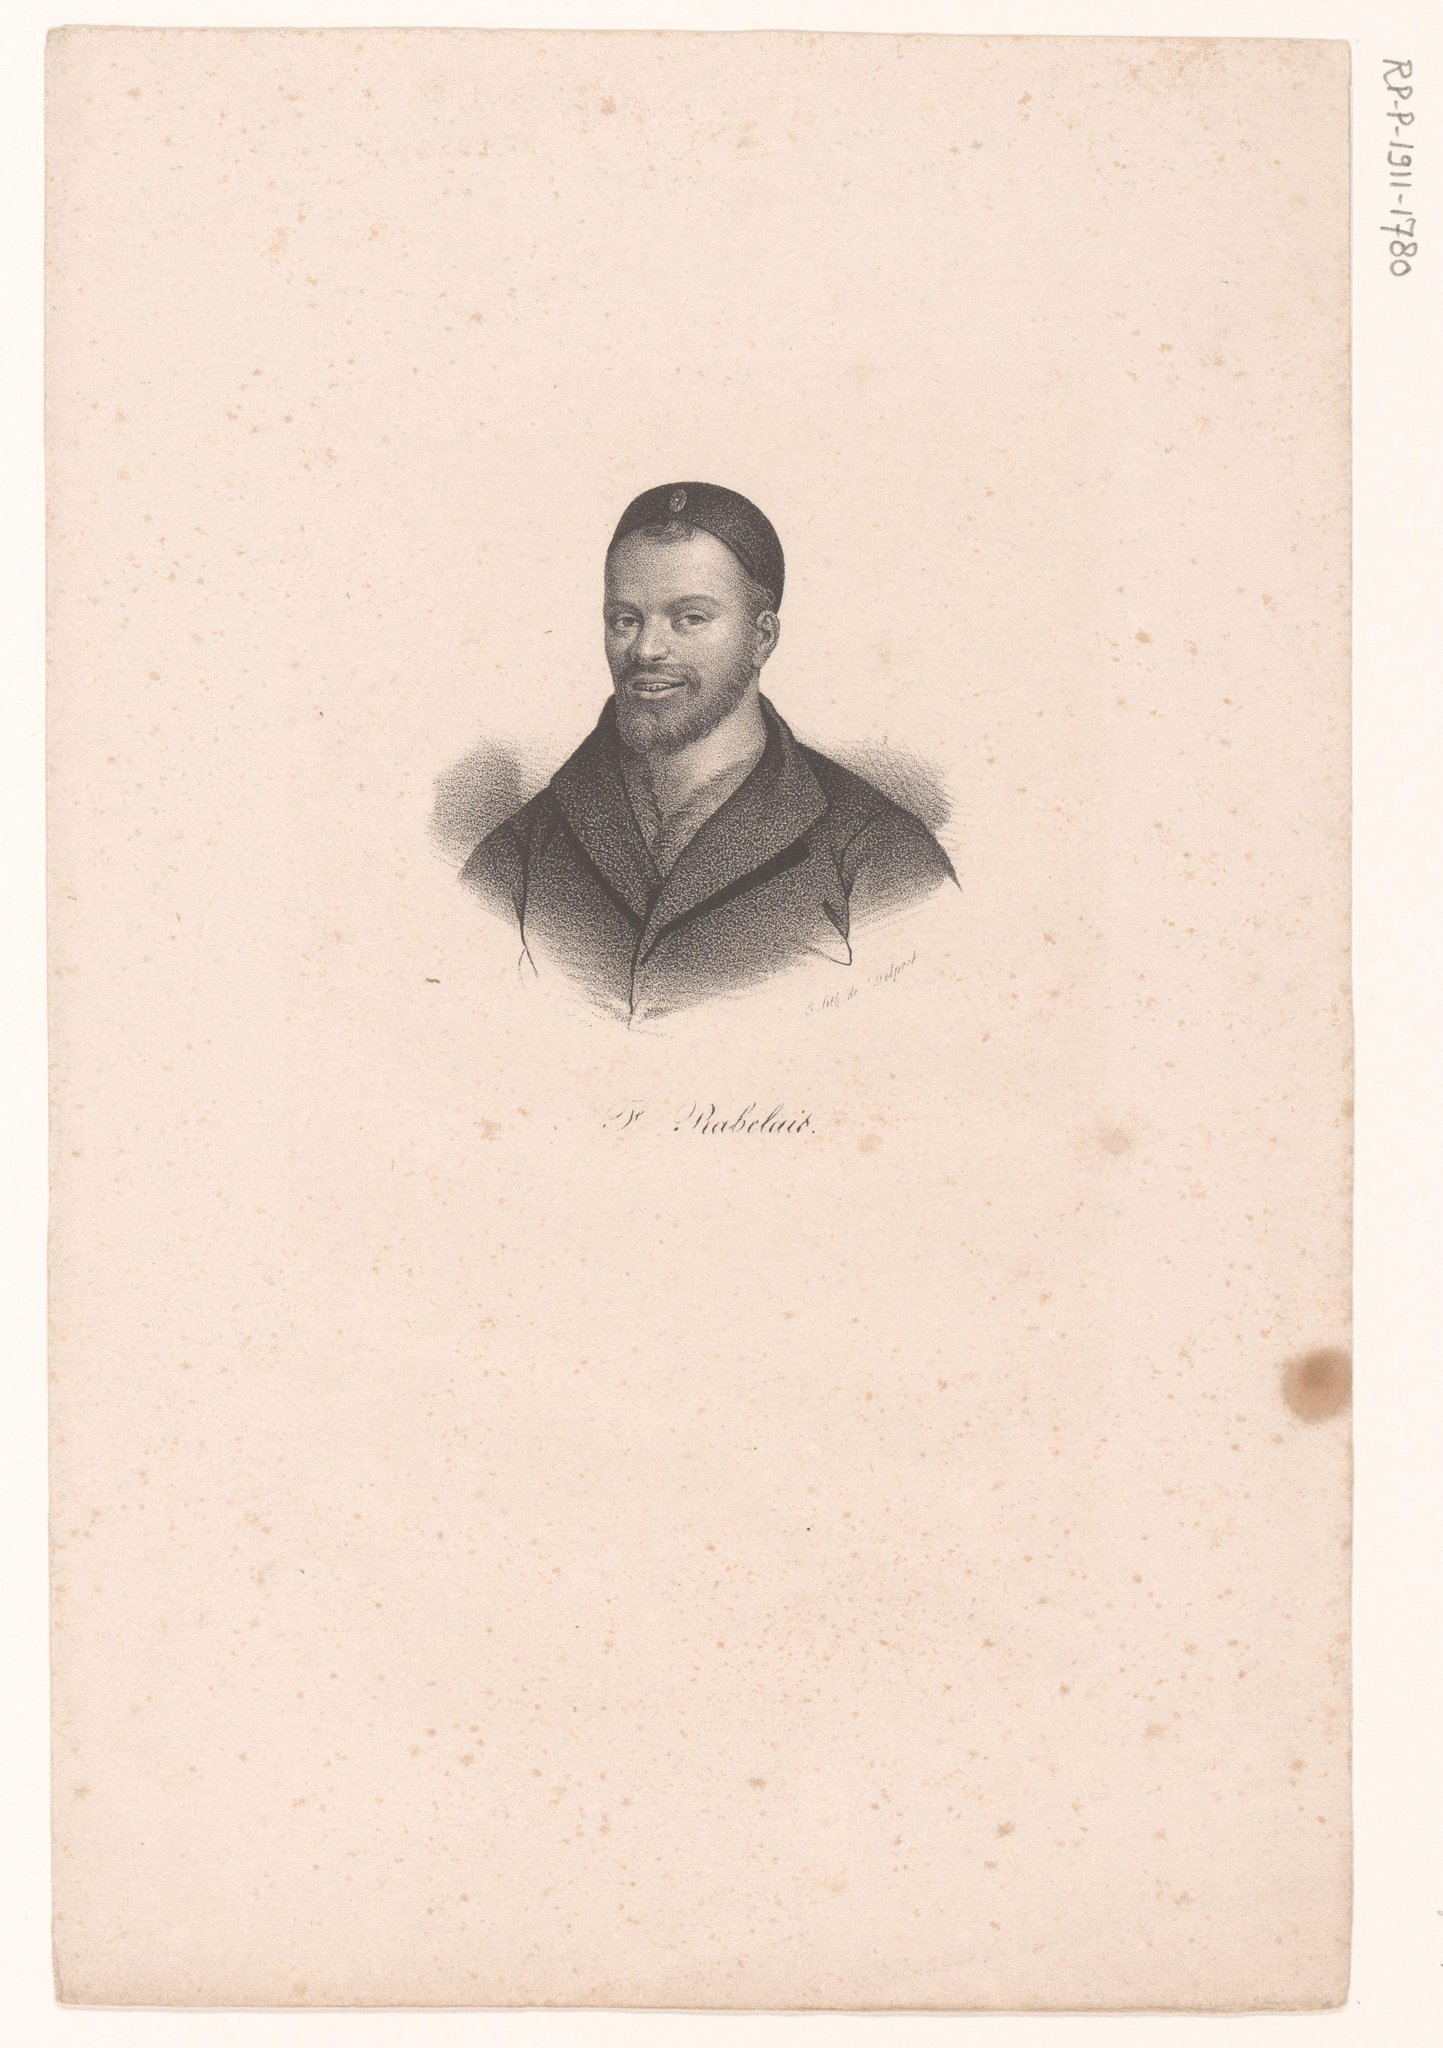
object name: print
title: Fr. Rabelais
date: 1818-1842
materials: paper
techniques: lithograph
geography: paris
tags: paris, historical persons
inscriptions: collector's mark: Lugt 2228a